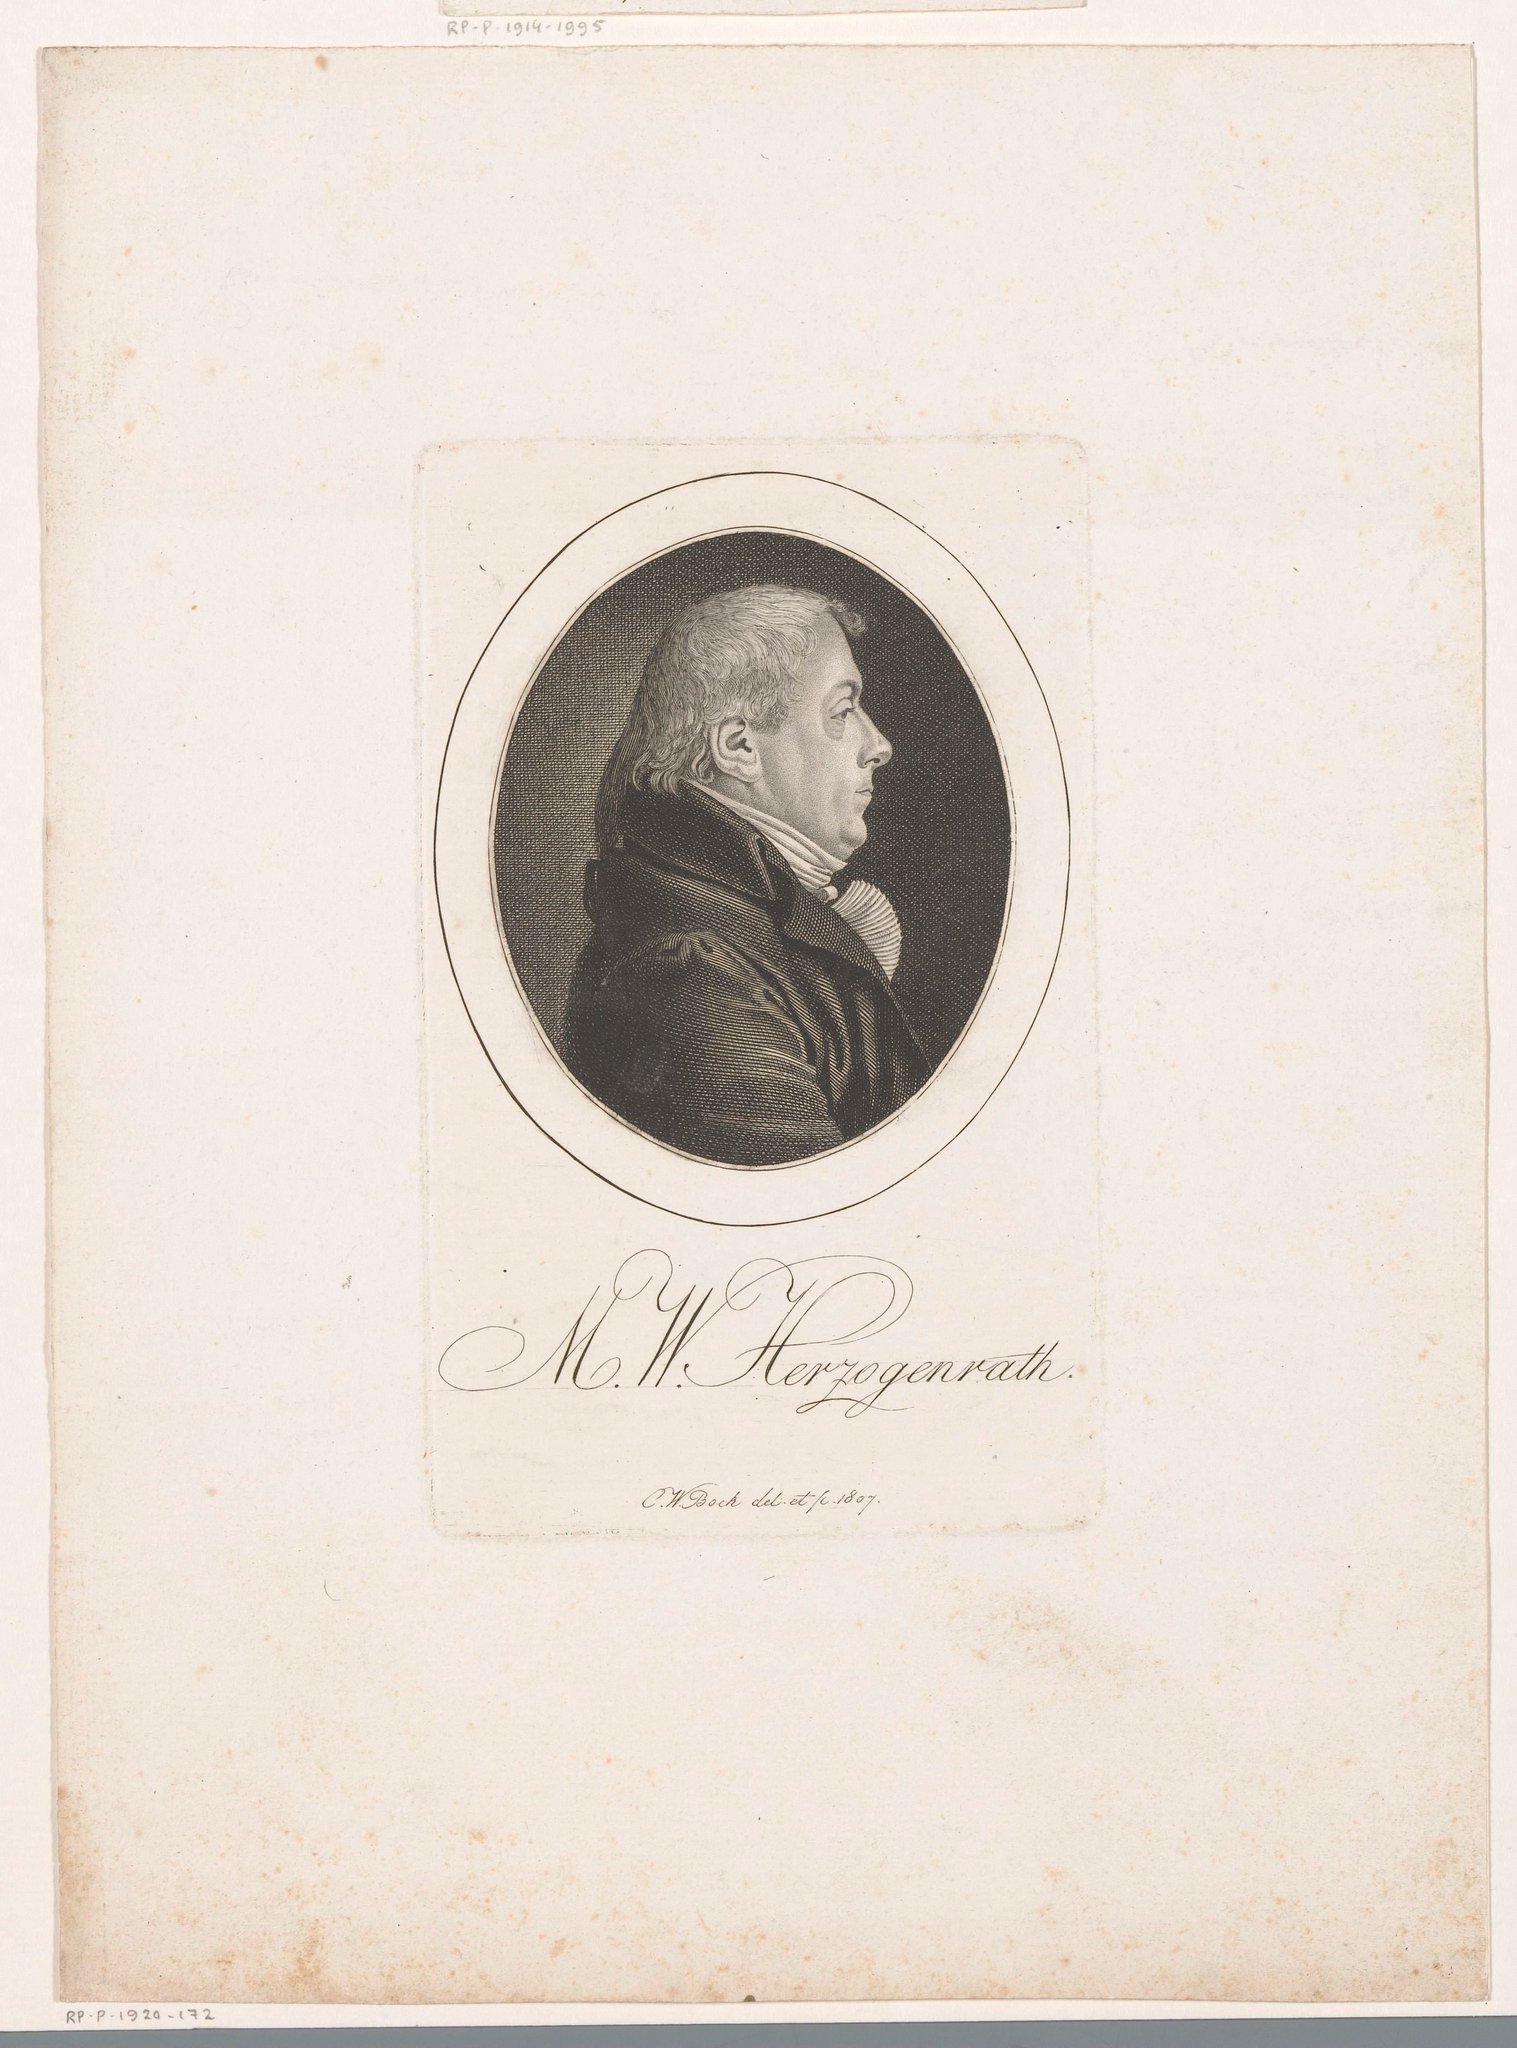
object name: print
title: Portret van M.W. Herzogenrath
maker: christoph wilhelm bock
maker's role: print maker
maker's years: 1755-1836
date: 1807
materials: paper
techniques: engraving, etching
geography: nuremberg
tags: historical persons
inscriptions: collector's mark: Lugt 2228